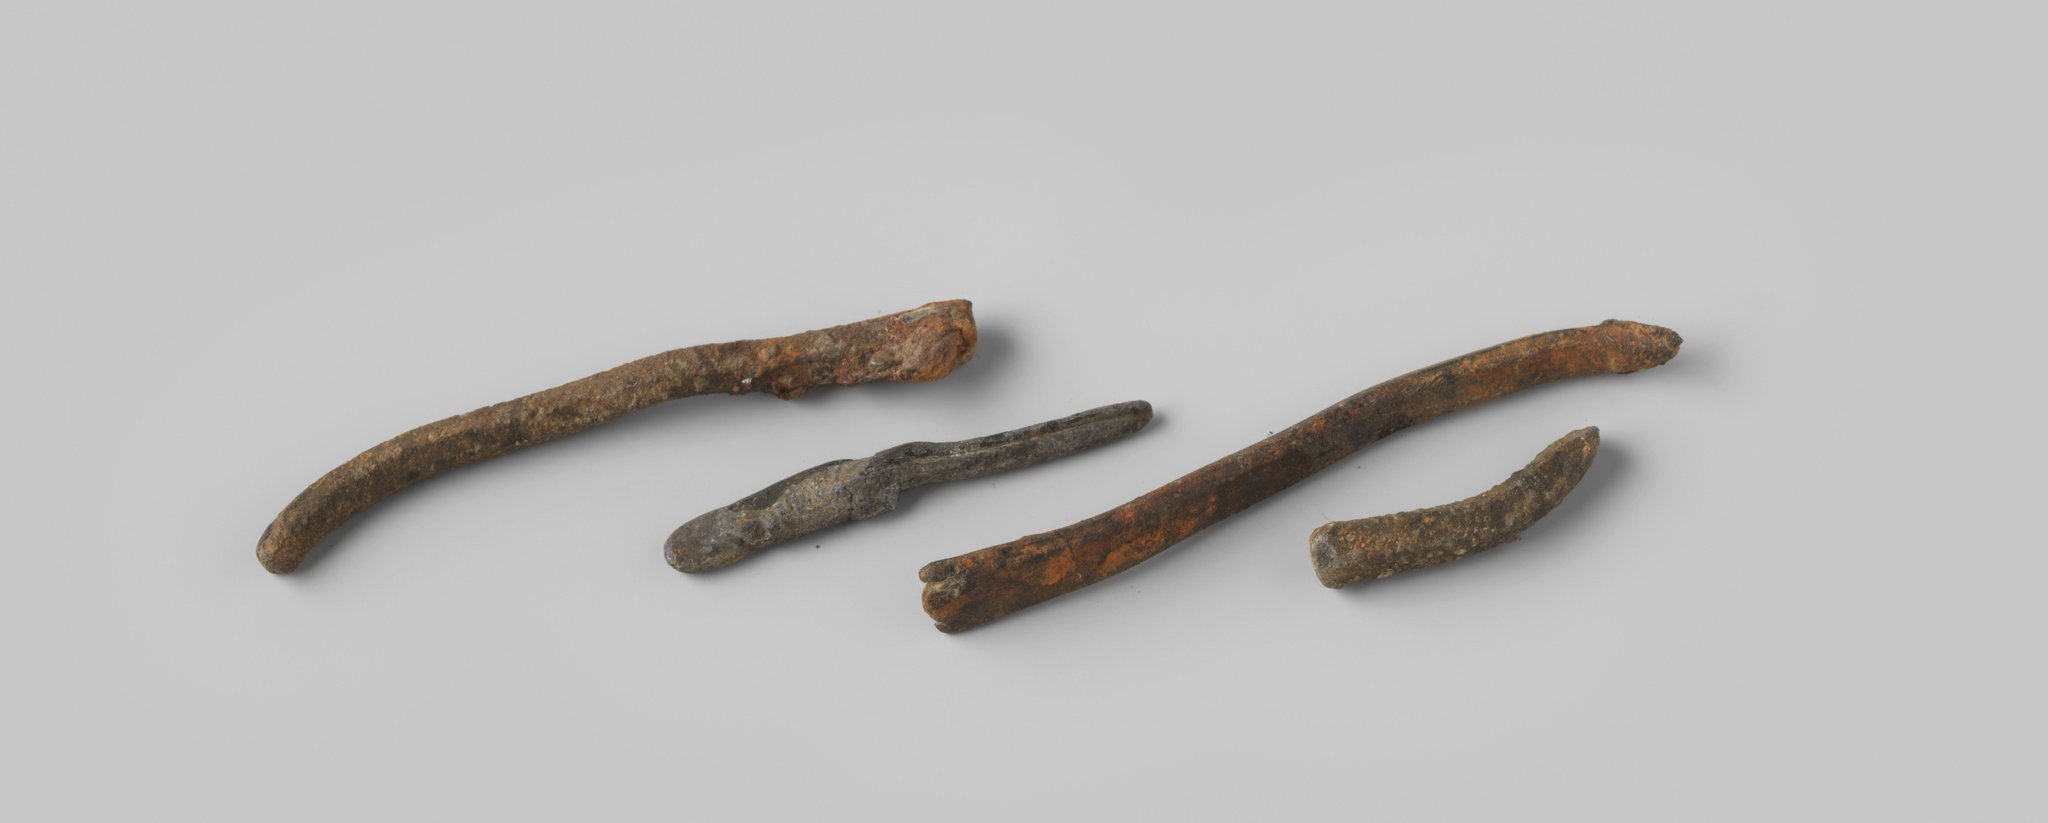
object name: spoon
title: Stelen van lepels uit het wrak van de Oost-Indiëvaarder Meresteijn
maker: Anonymous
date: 1693-1702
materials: tin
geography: netherlands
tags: cape of good hope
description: Vier massieve ronde (deels gecorrodeerd) stelen van tinnen lepels met roestaanslag. Spoon, stem.